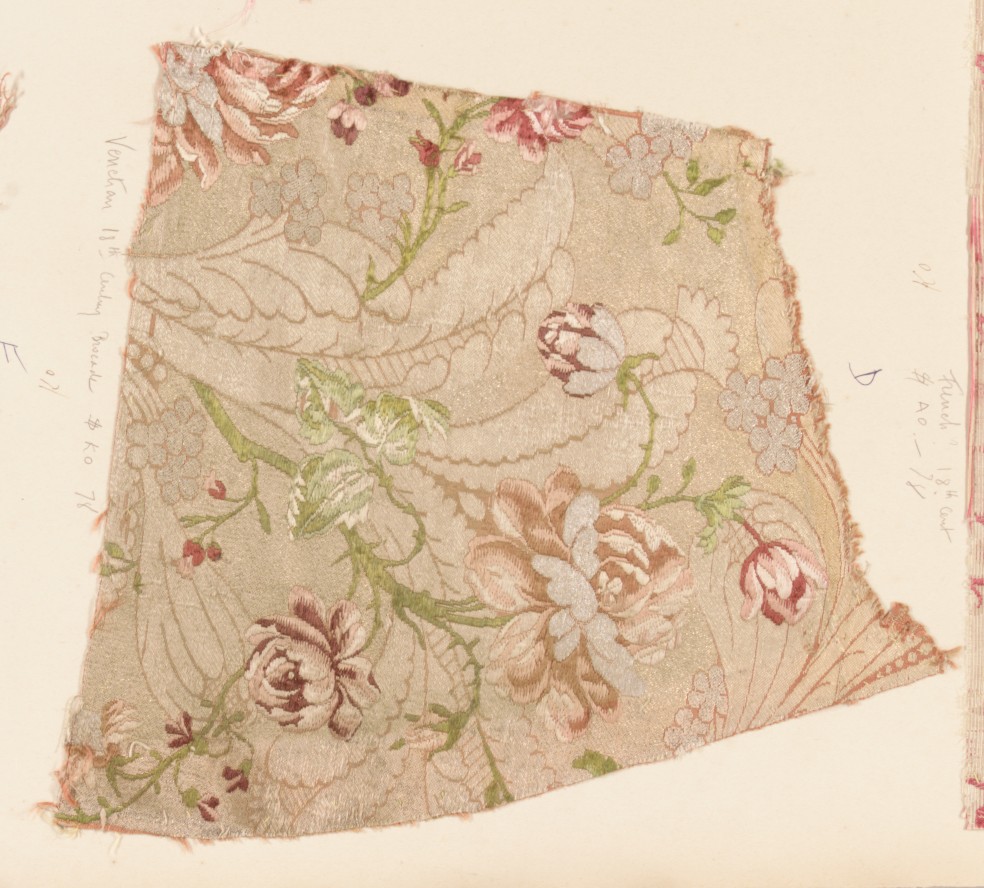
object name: fragment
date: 1701-1800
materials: metal thread, silk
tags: flowers,leaves